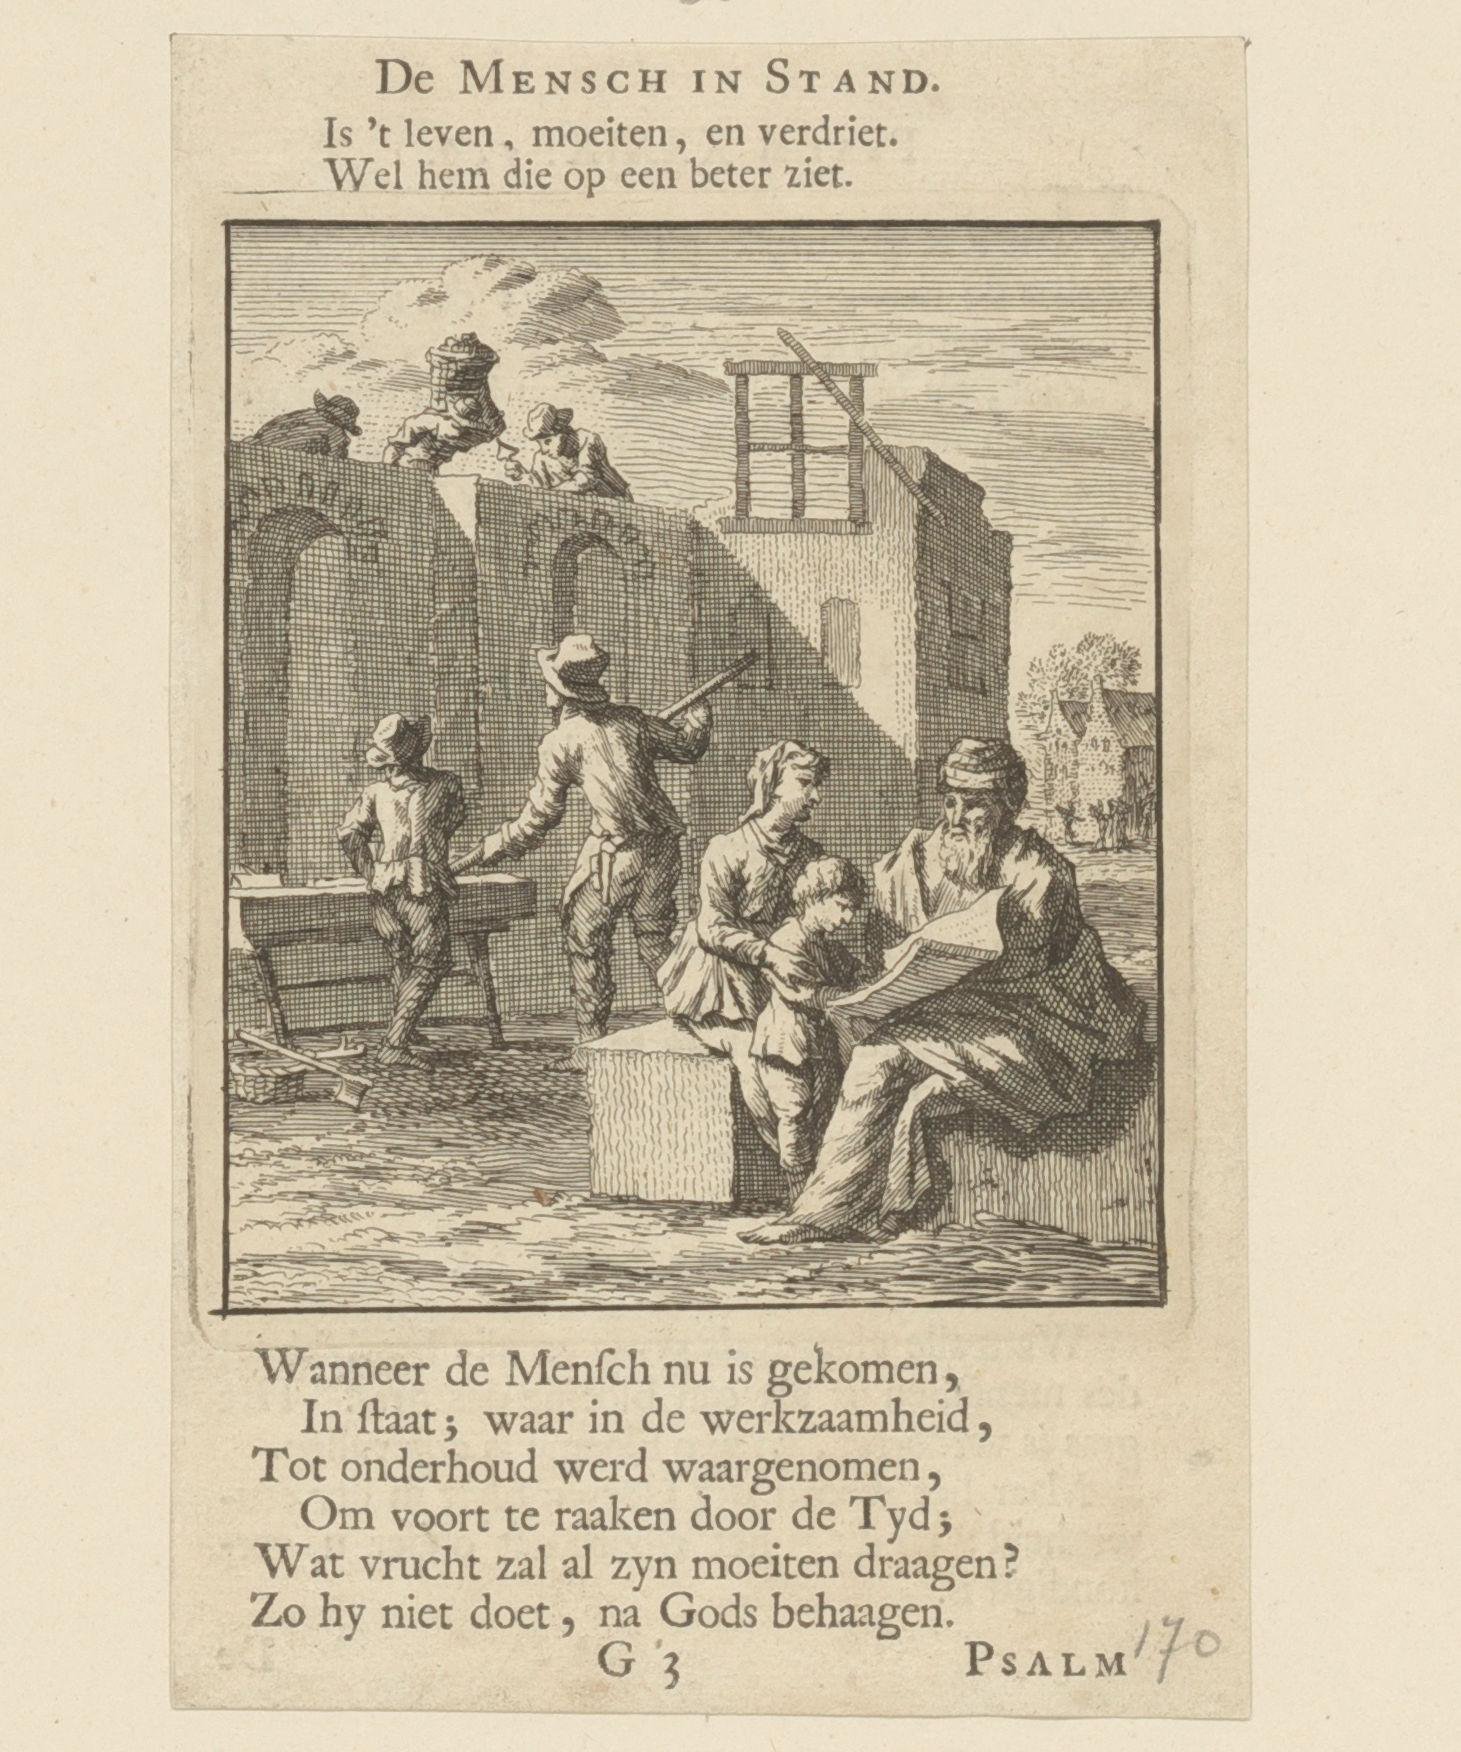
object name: print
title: Bouwen van een huis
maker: jan luyken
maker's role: draughtsman, print maker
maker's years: 1649-1712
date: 1712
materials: paper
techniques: etching, letterpress printing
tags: funerary ceremonial, building-site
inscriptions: collector's mark: Lugt 1641, stamp, stamp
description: Onderaan een zesregelig vers. Onderwerpsrubrieken binnen de Atlas Zeden en Gewoonten: Zeden en Gewoonten in Engeren Zin, Des menschen beging, midden en einde, Kinderleven – Kinderspel en Kinderprenten.